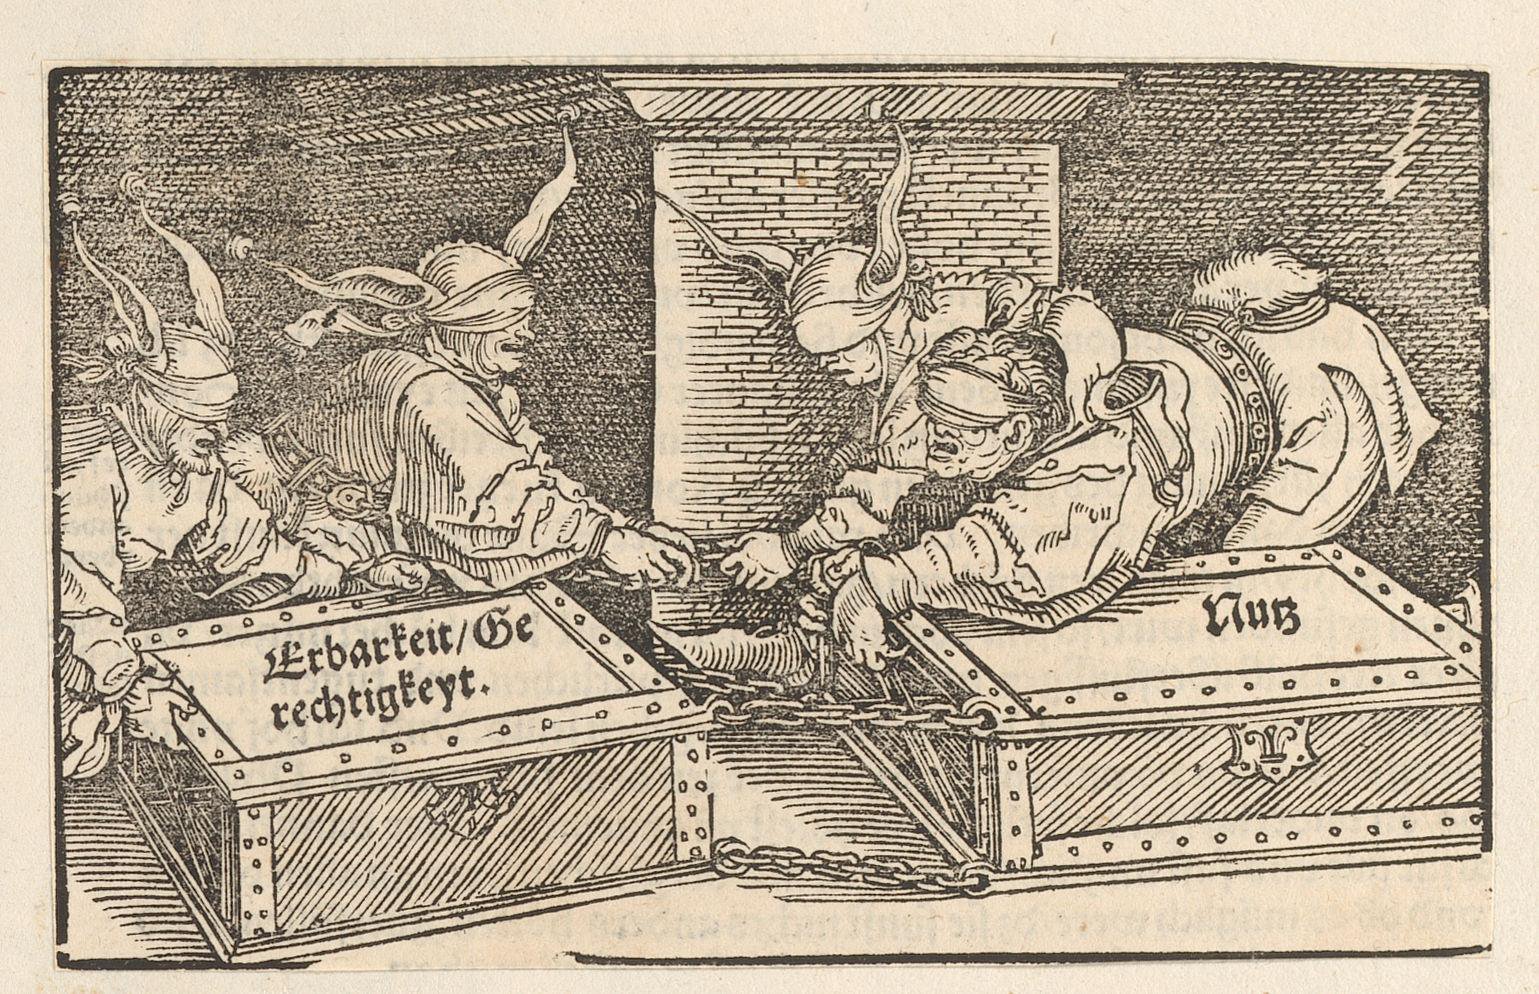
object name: album leaf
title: Geblinddoekte mannen met ezelsoren bij twee aan elkaar geketende kisten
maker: Anonymous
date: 1514-1532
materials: paper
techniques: letterpress printing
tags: court jester, court fool, virtuousness; 'amor di virtù', 'attione virtuosa', 'guida sicura de' veri honori', 'virtù', 'virtù insuperabile' (ripa), wisdom of the fool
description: Deze prent is gebruikt in: Petrarca, Francesco. Von der Artzney bayder Glück, des guten und widerwertigen: unnd weß sich ain yeder inn Gelück und Unglück halten sol (...). Augsburg: Heinrich Steiner, 1532. Deze uitgave is ook bekend onder de titel 'Trostspiegel in Glück und Unglück'.